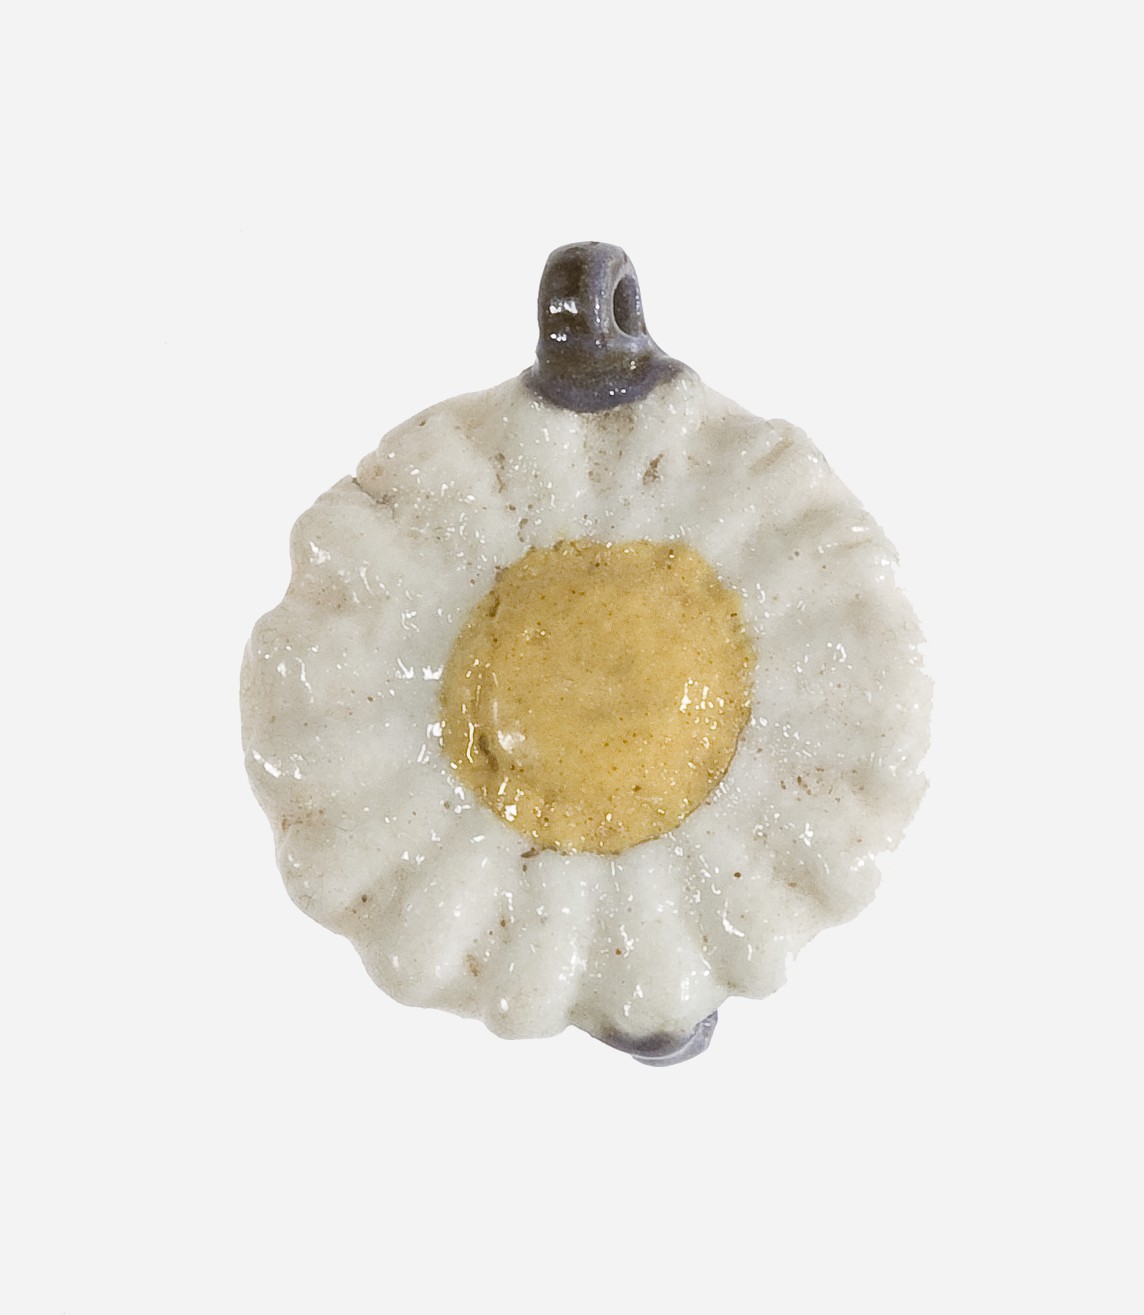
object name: bead, daisy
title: Bead in the Form of a daisy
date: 1390-1352 BCE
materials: faience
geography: egypt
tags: daisies